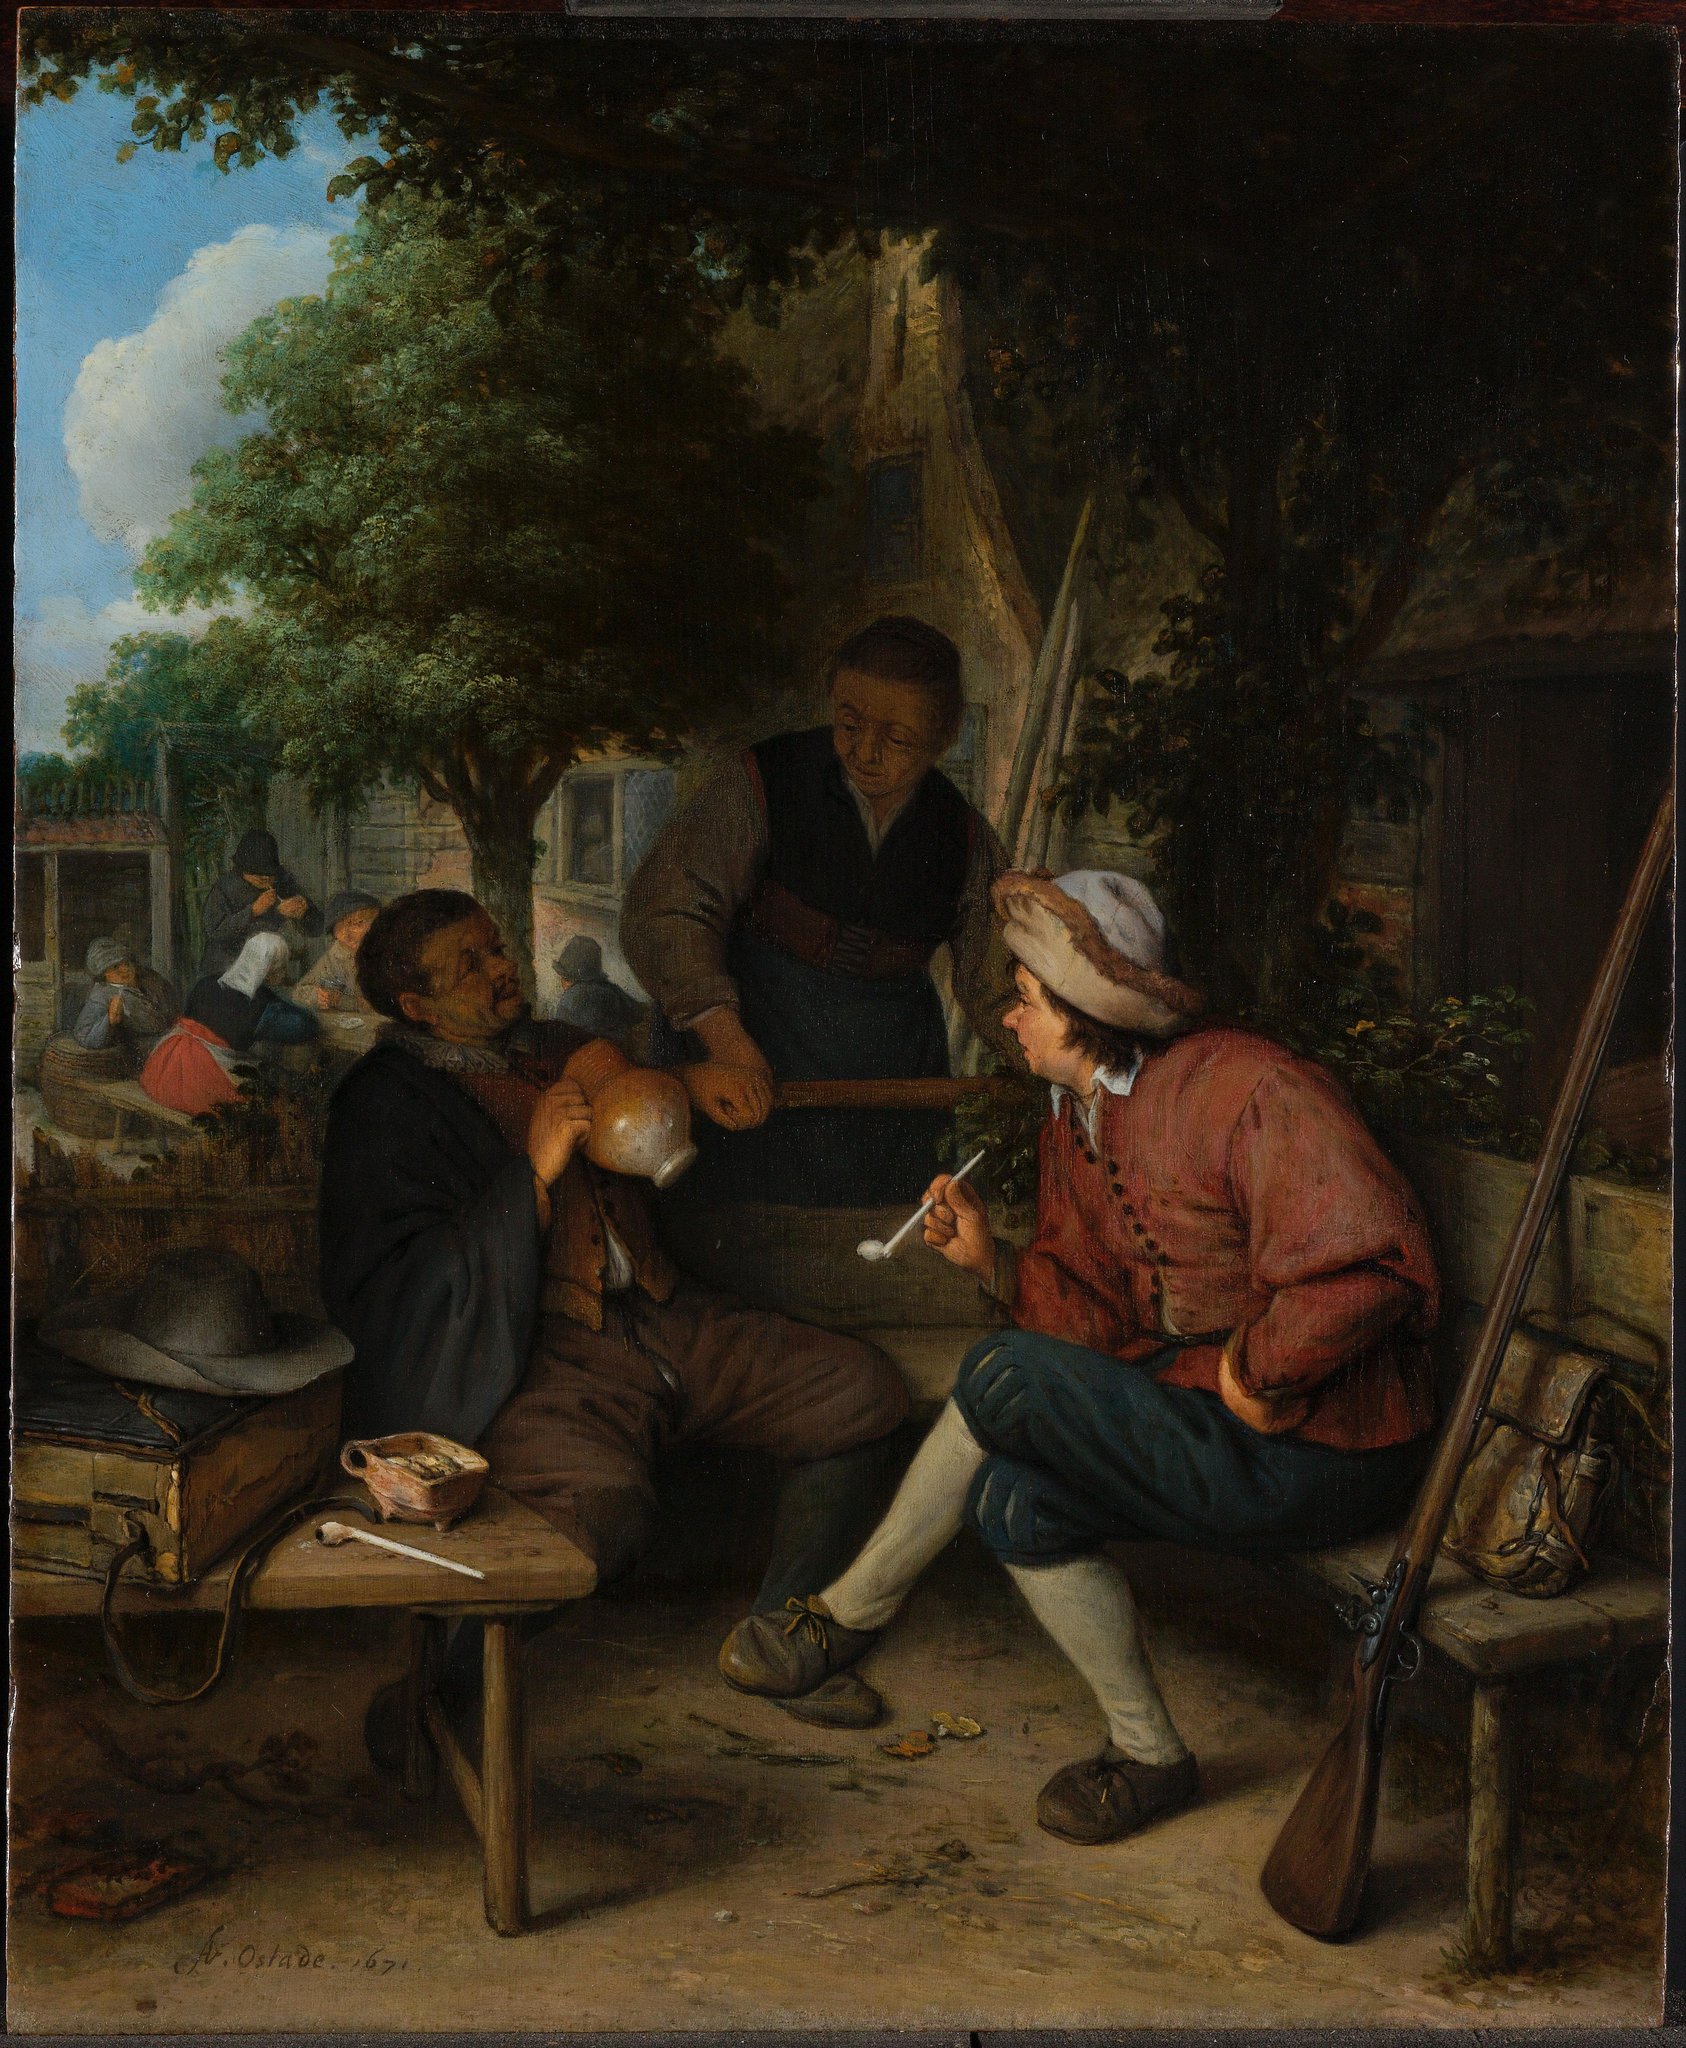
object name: painting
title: Travellers at Rest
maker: adriaen van ostade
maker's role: draughtsman, painter, print maker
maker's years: 1610-1685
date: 1671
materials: oil, panel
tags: inn, coffee-house, public house, etc., pipe ~ tobacco, jar, jug (used as drinking-vessel), (traveller) resting in the open air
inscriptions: signature and date, bottom left: ‘Av. Ostade . 1671’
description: After 1670, Van Ostade mainly painted outdoor scenes, extolling unhurried, simple country life. The men drink beer and smoke their pipes. In the 17th century, Dutch people smoked so much that, according to foreign travellers, the smell of the Low Countries was the smell of tobacco. The most and best tobacco was cultivated in North and South America by people in slavery and shipped to the Netherlands for resale to other countries.